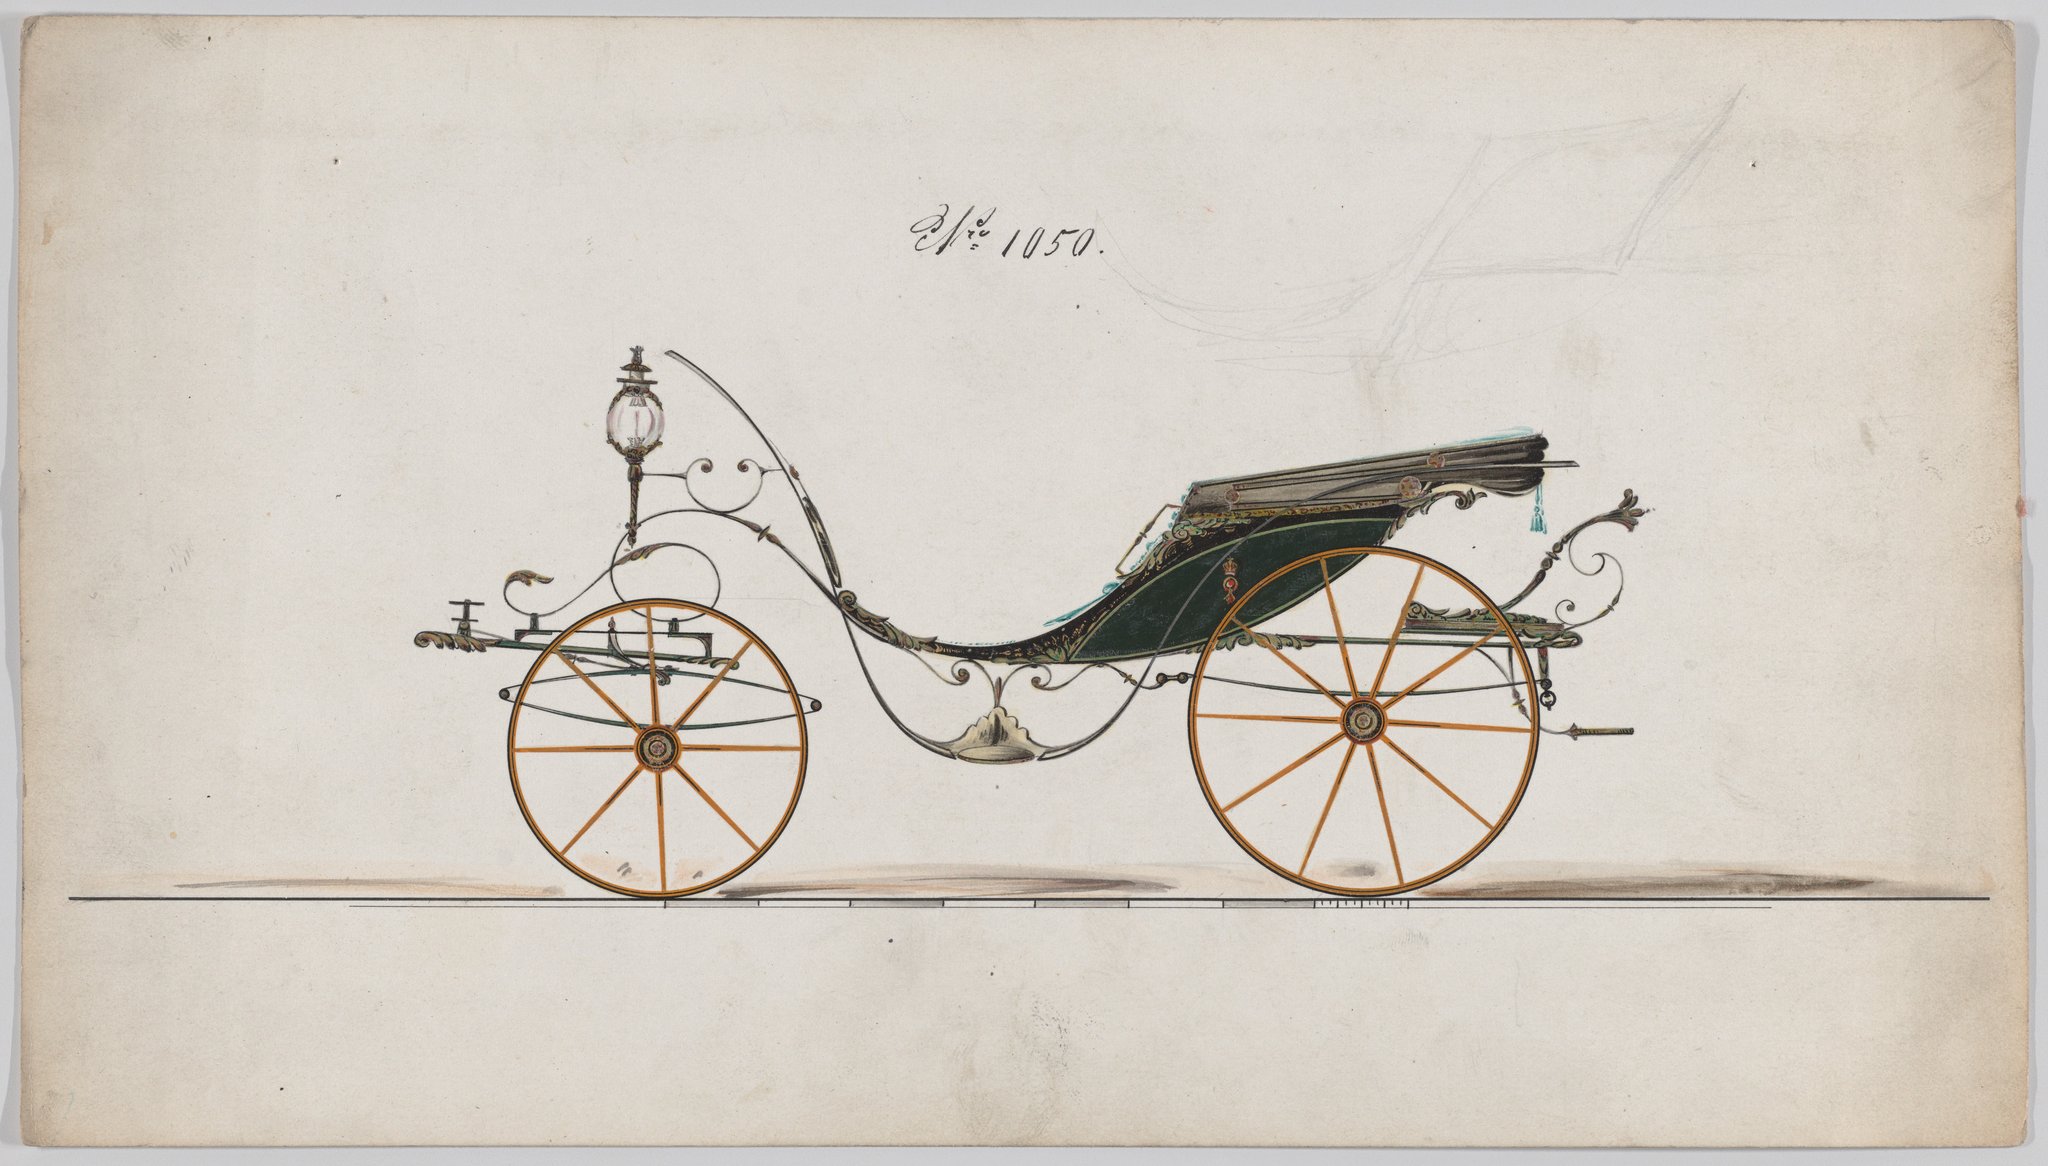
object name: drawing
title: Victoria # 1050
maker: brewster & co.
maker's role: manufacturer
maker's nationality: american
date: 1870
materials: gouache, gum arabic, ink, watercolor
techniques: pen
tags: carriages